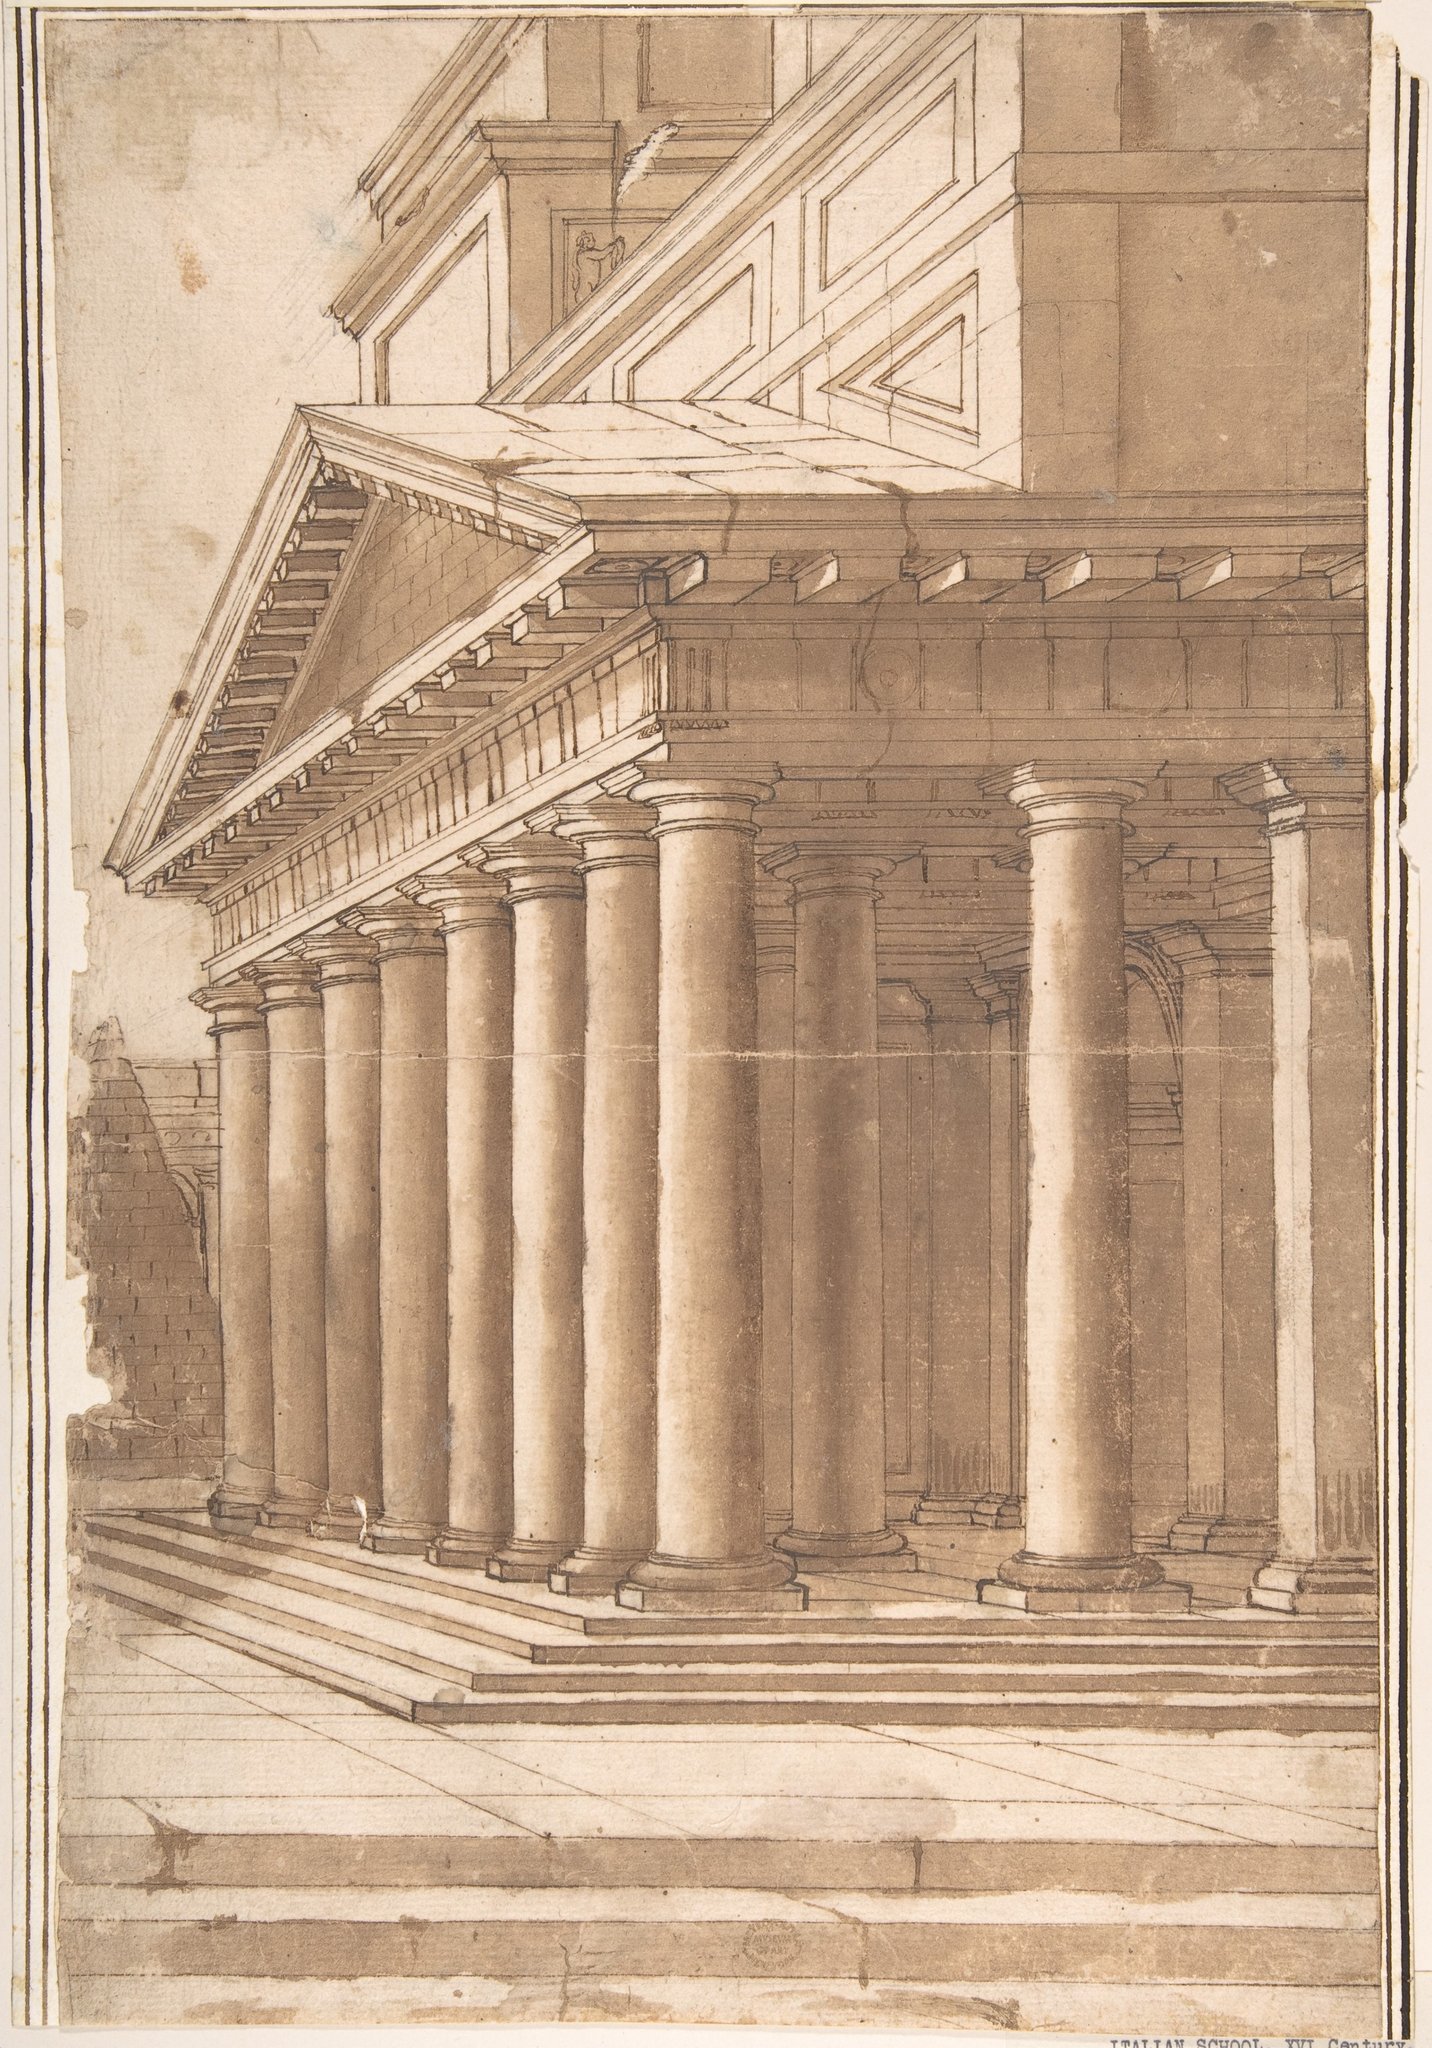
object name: drawing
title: Portico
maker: anonymous, italian, 16th century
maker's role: artist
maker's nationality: italian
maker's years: 1550-1600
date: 1501-1600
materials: ink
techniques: pen, wash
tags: architecture